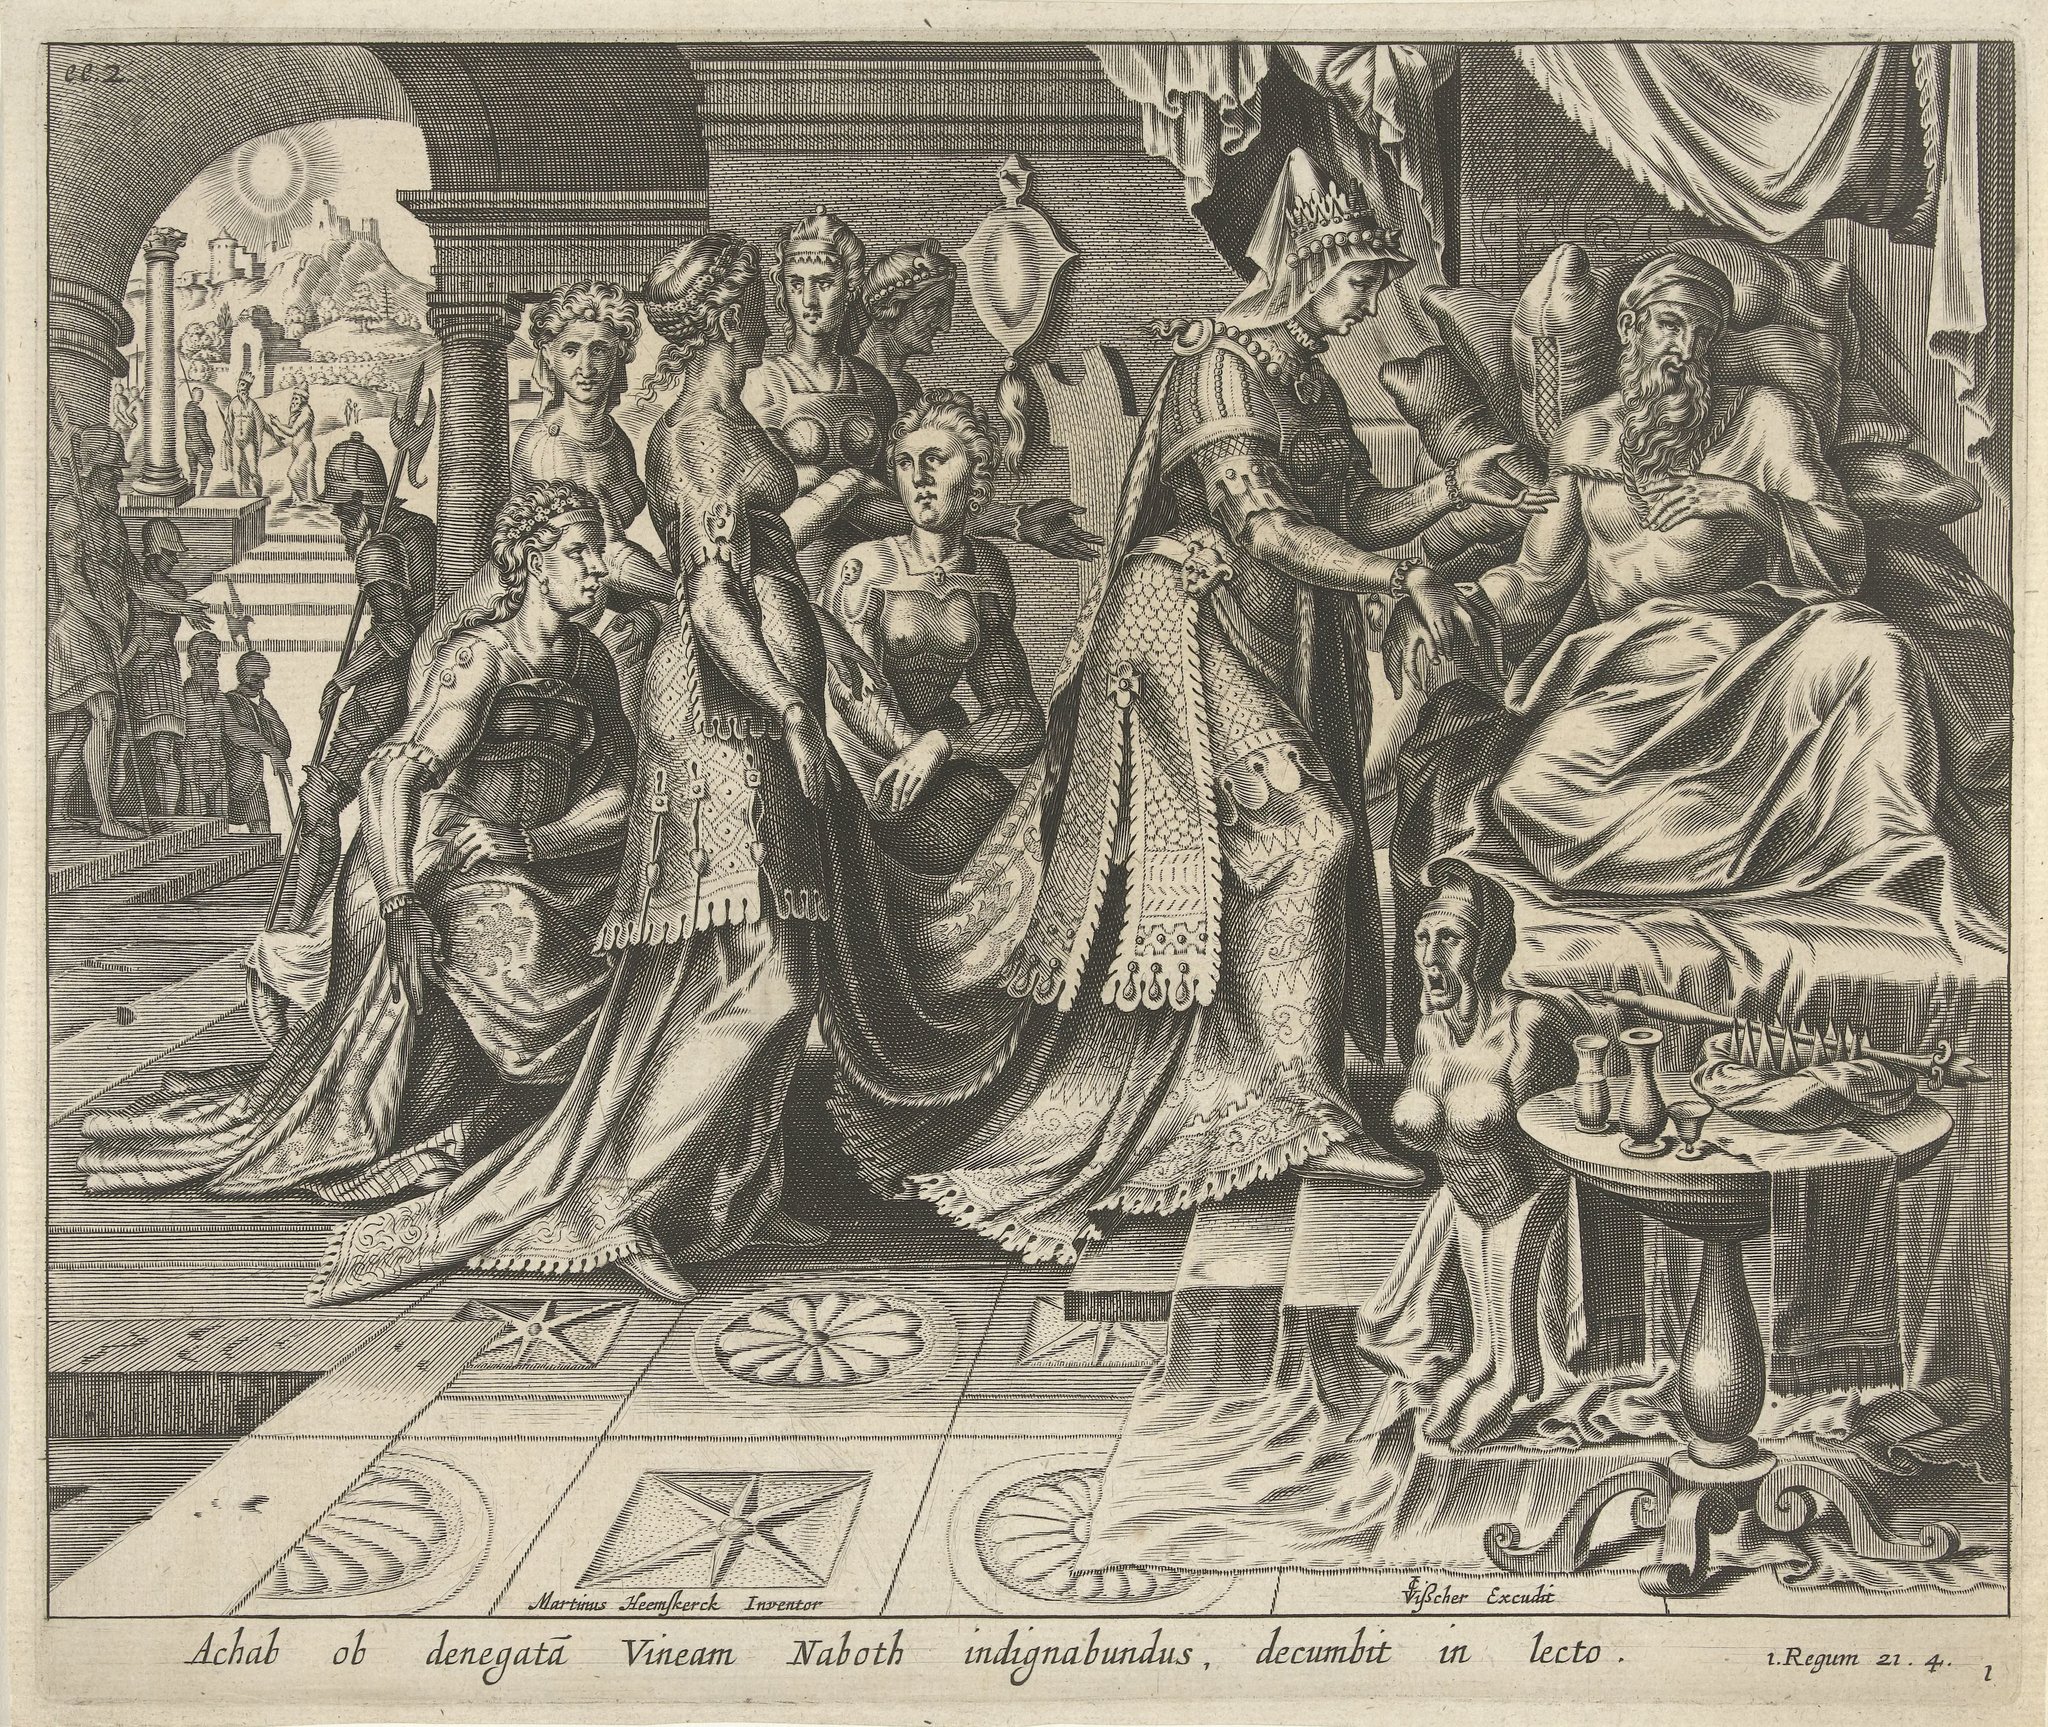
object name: print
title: Geschiedenis van Achab en Nabot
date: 1600-1652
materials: paper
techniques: engraving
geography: amsterdam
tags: ahab becomes depressed, lies down on his bed, faces the wall and refuses to eat ~ naboth's vineyard, naboth refuses to sell his vineyard to ahab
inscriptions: collector's mark: Lugt 2228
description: Koning Achab ligt teleurgesteld op bed omdat Nabot weigert hem zijn wijngaard te verkopen. Zijn vrouw Izebel staat naast het bed en belooft hem dat ze ervoor zal zorgen dat hij Nabots wijngaard krijgt. Achter Izebel staat een groepje dienaressen en in de deuropening paleiswachten. Links op de achtergrond een voorstelling van wat vooraf ging: koning Achab vraagt Nabot zijn wijngaard af te staan. Onder de voorstelling een vers in het Latijn.